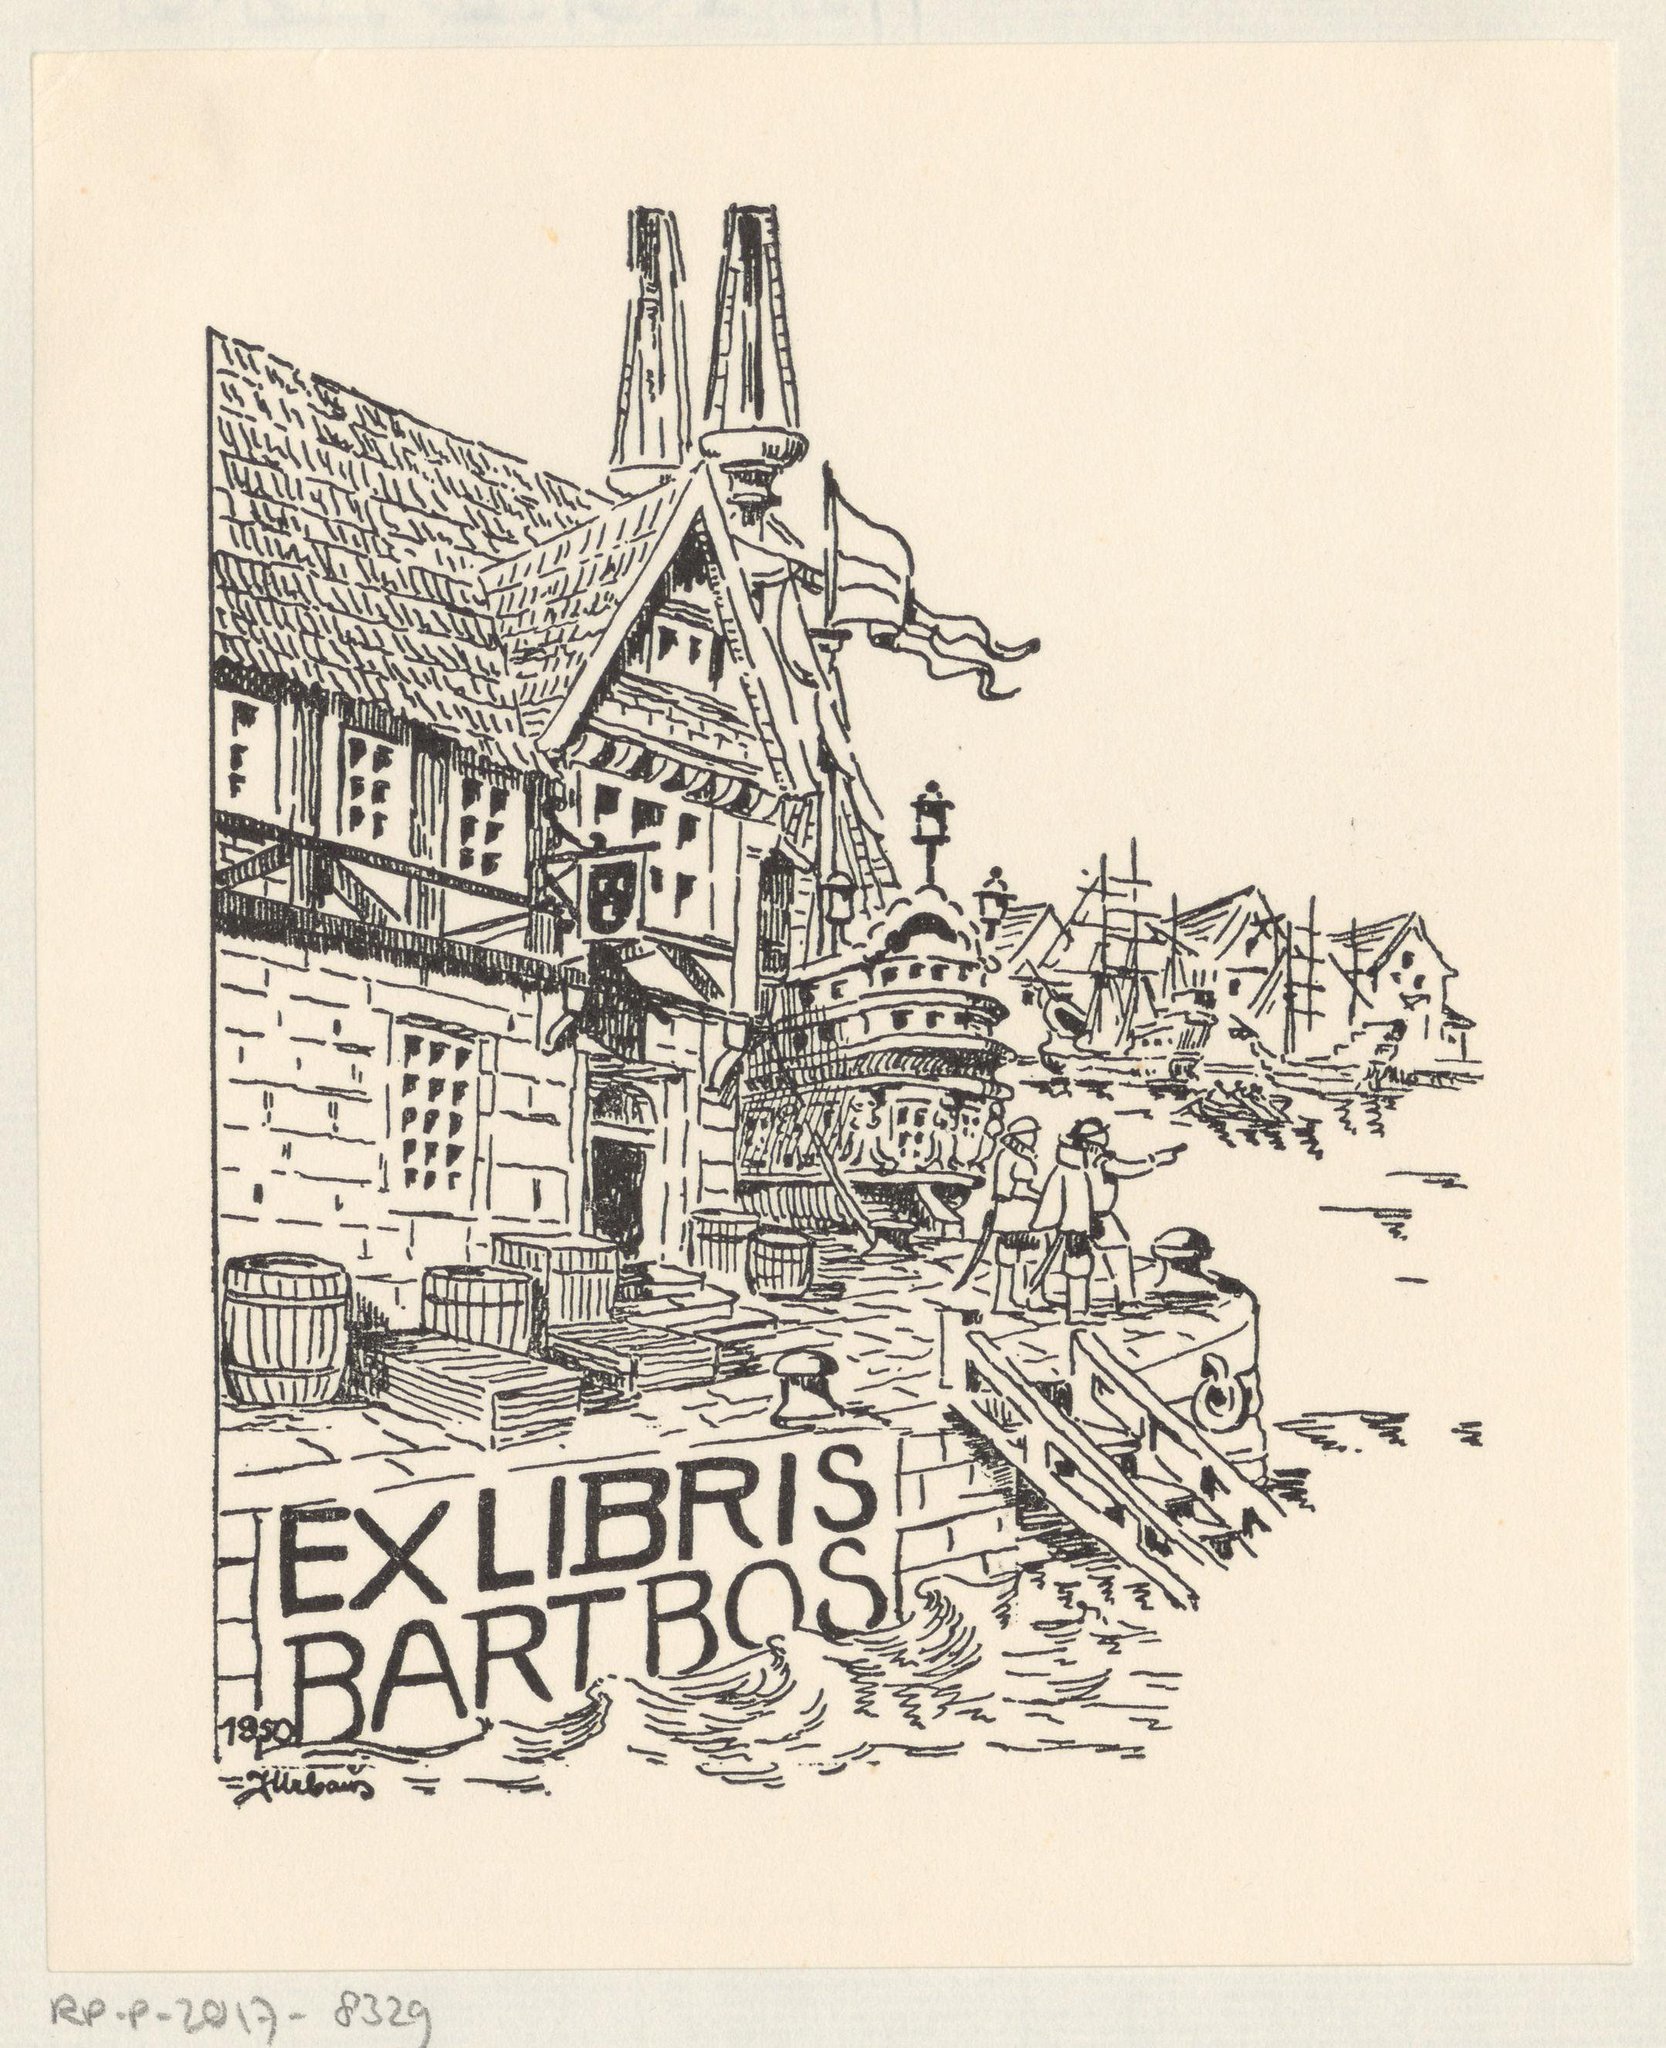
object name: bookplate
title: Ex libris van Bart Bos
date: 1950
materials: paper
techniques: printing block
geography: czech republic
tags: bart bos, harbour, sailing-ship, sailing-boat, prospect of city, town panorama, silhouette of city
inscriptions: workshop stamp: ‘Ivo Urban cliche/ Ceskoslovensko 1950’